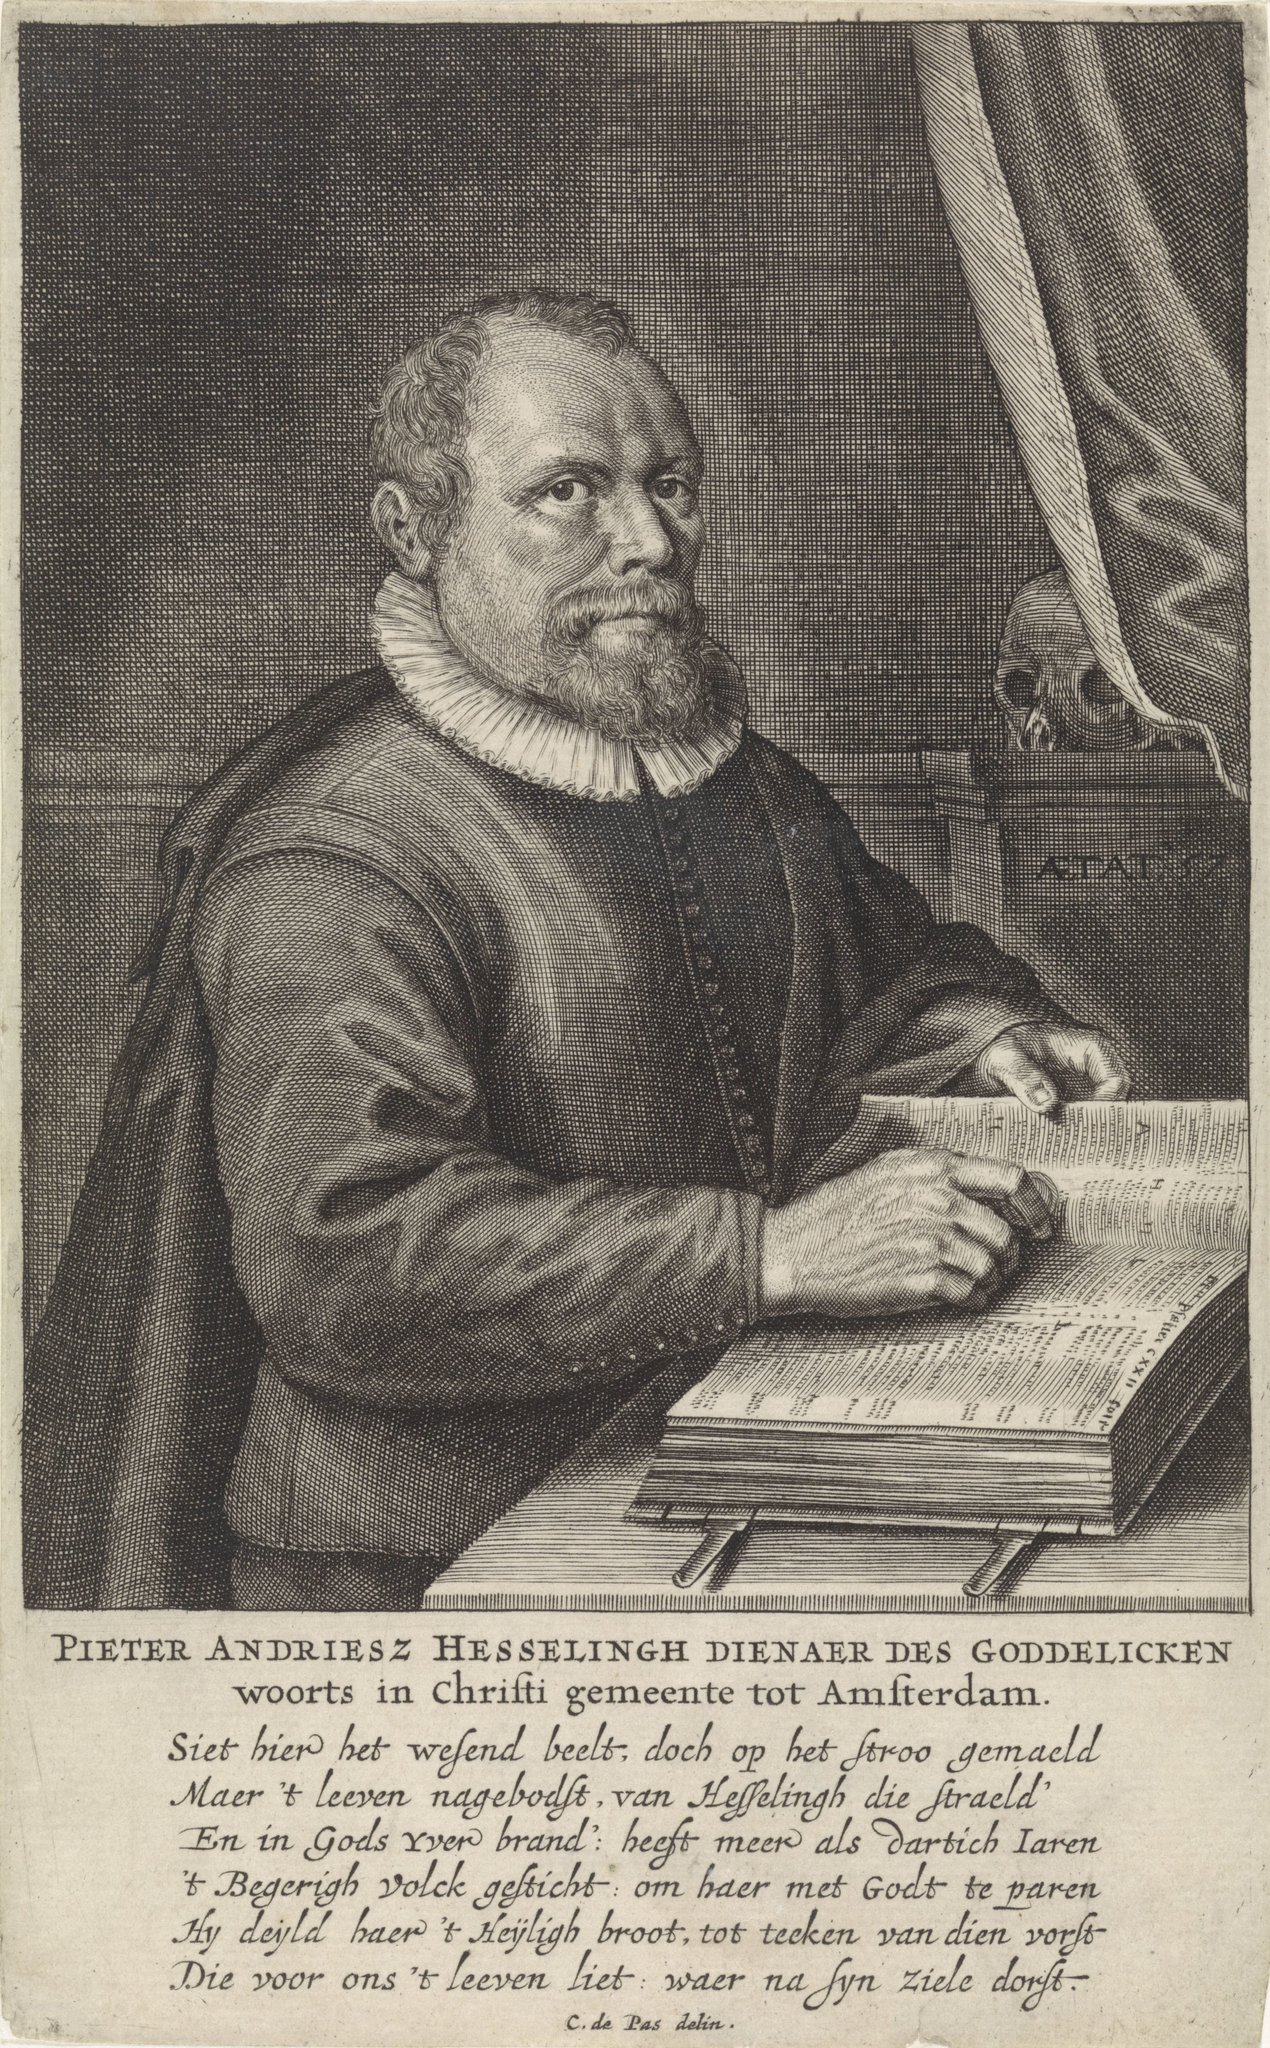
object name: print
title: Portret van Pieter Andriesz Hesseling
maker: crispijn van de passe (ii)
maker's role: draughtsman, print maker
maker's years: 1594-1670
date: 1604-1670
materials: paper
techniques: engraving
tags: reading the bible or other religious books, death's head, skull (symbol of death)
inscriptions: collector's mark: Lugt 240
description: Portret van de predikant Pieter Andriesz Hesseling, op 57-jarige leeftijd, die de bijbel leest. In de marge de naam en functie van de geportretteerde en een zesregelig lofdicht in het Nederlands.